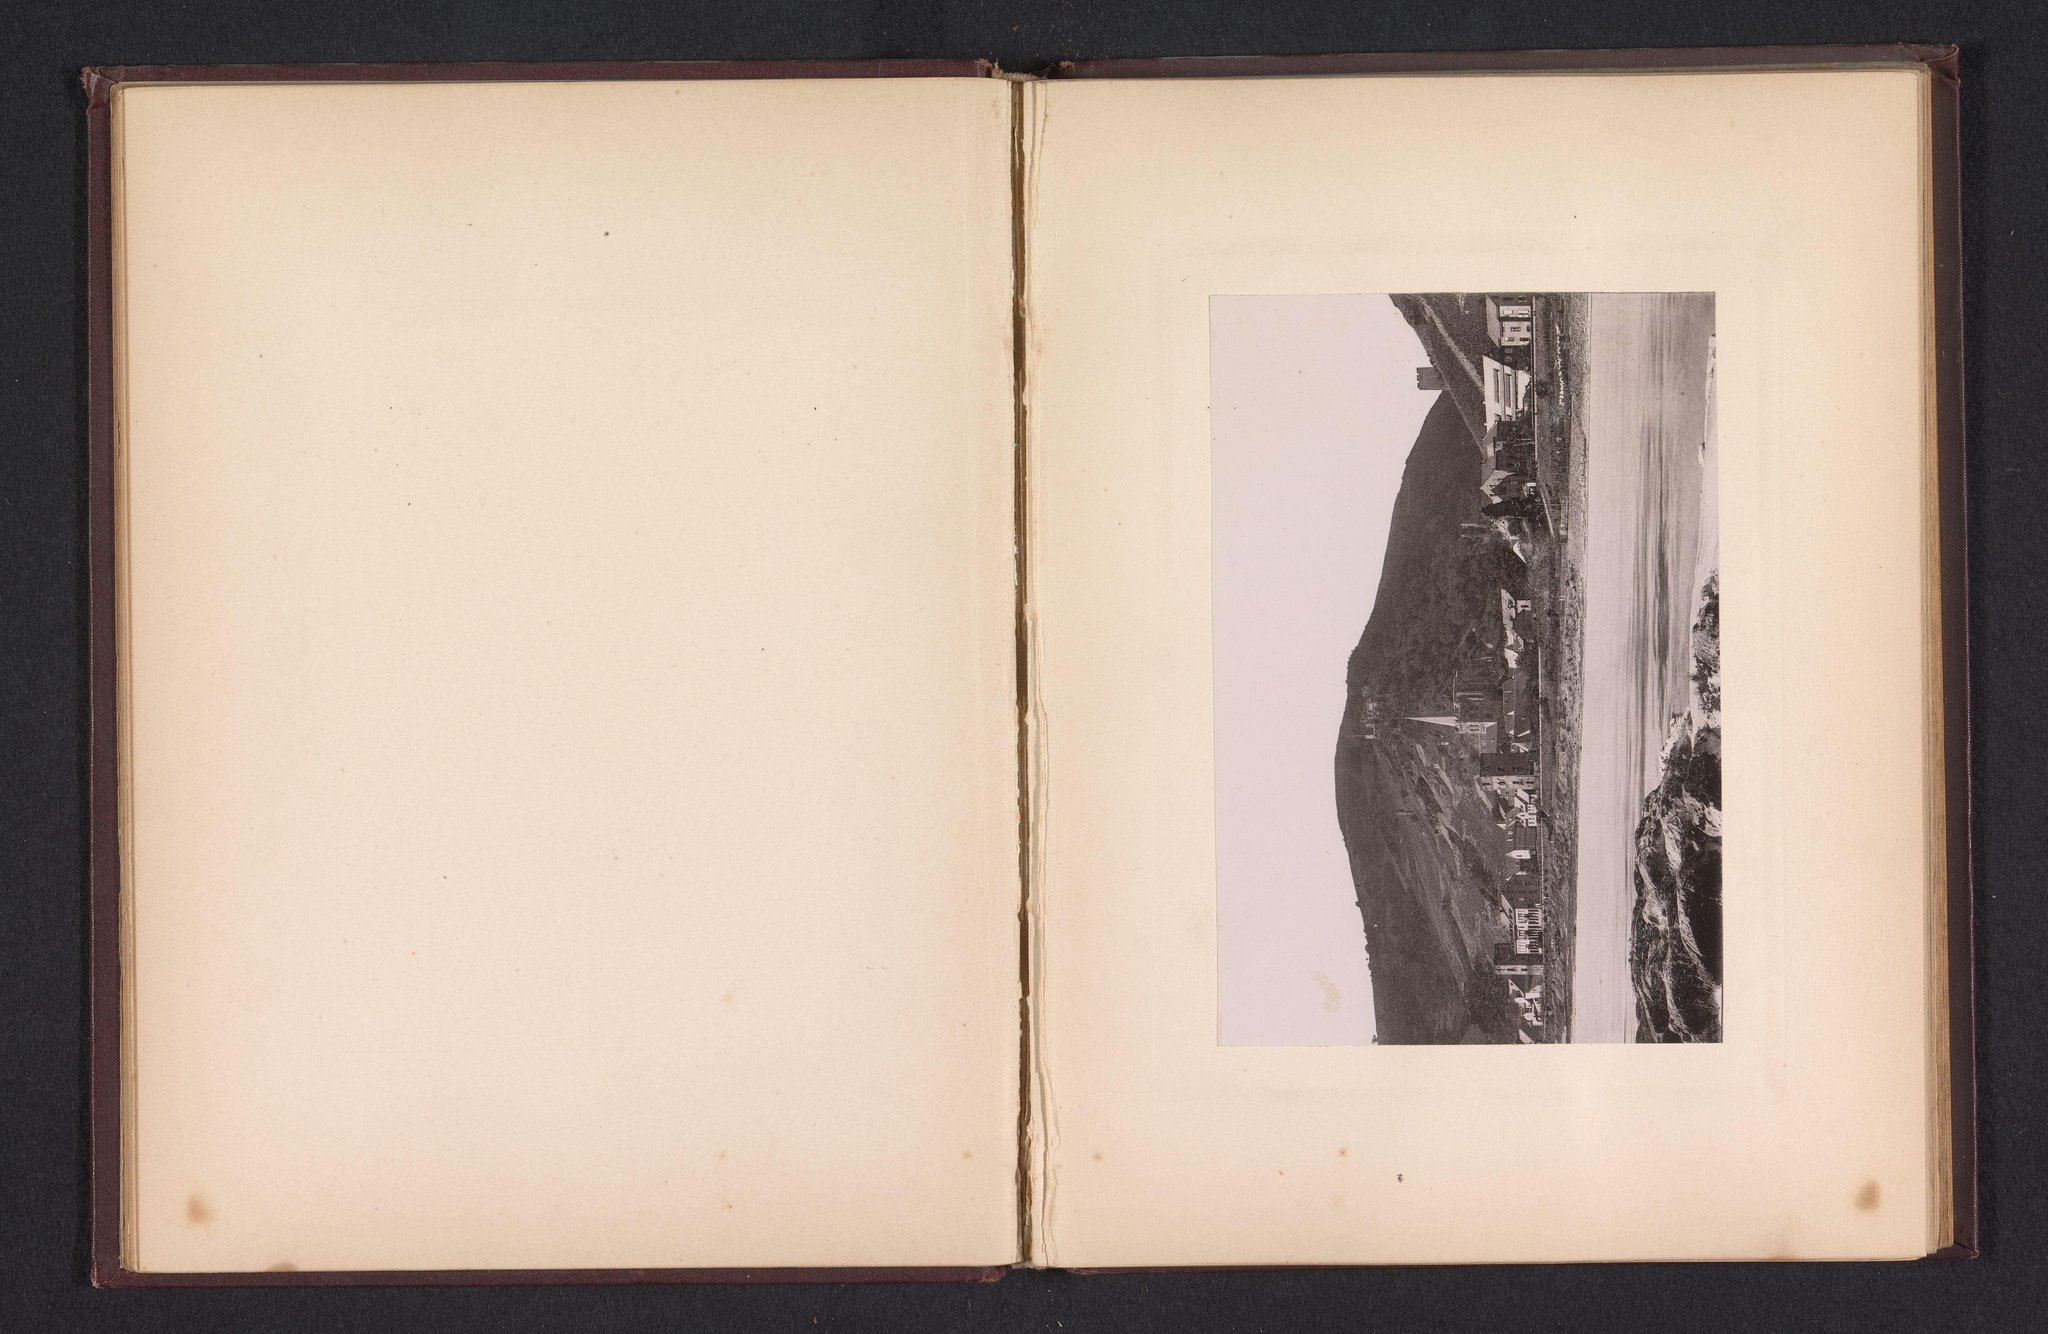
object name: page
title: Gezicht op Bacharach over de Rijn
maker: Anonymous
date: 1881-1891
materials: paper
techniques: photograph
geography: dresden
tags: city-view, and landscape with man-made constructions, river